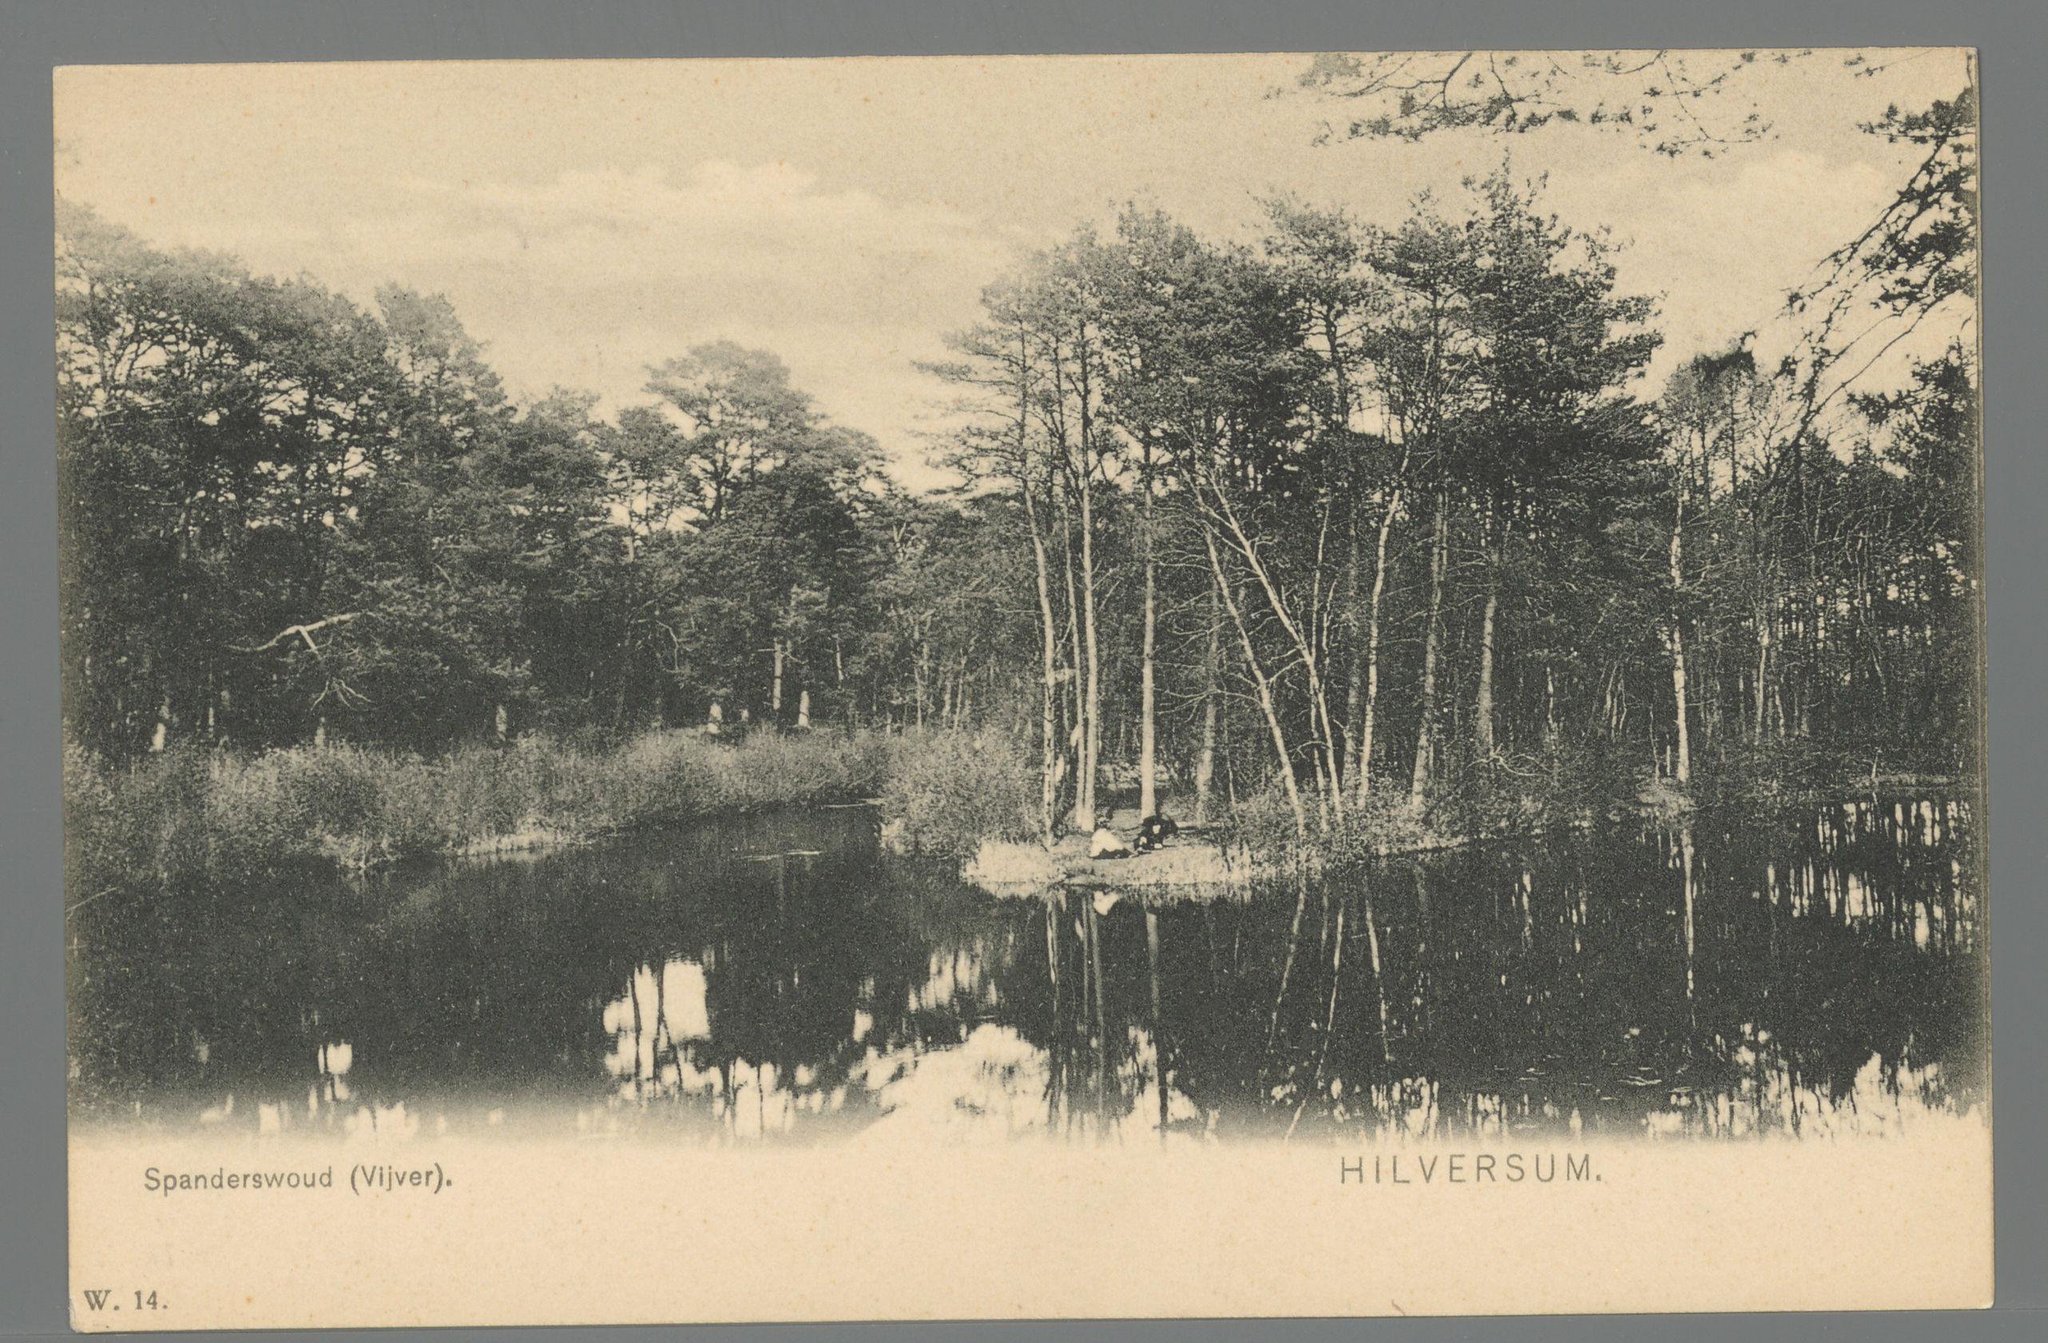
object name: photomechanical print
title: Spanderswoud (vijver). Hilversum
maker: Anonymous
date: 1892-1905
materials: cardboard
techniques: photograph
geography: hilversum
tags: forest, wood, pond